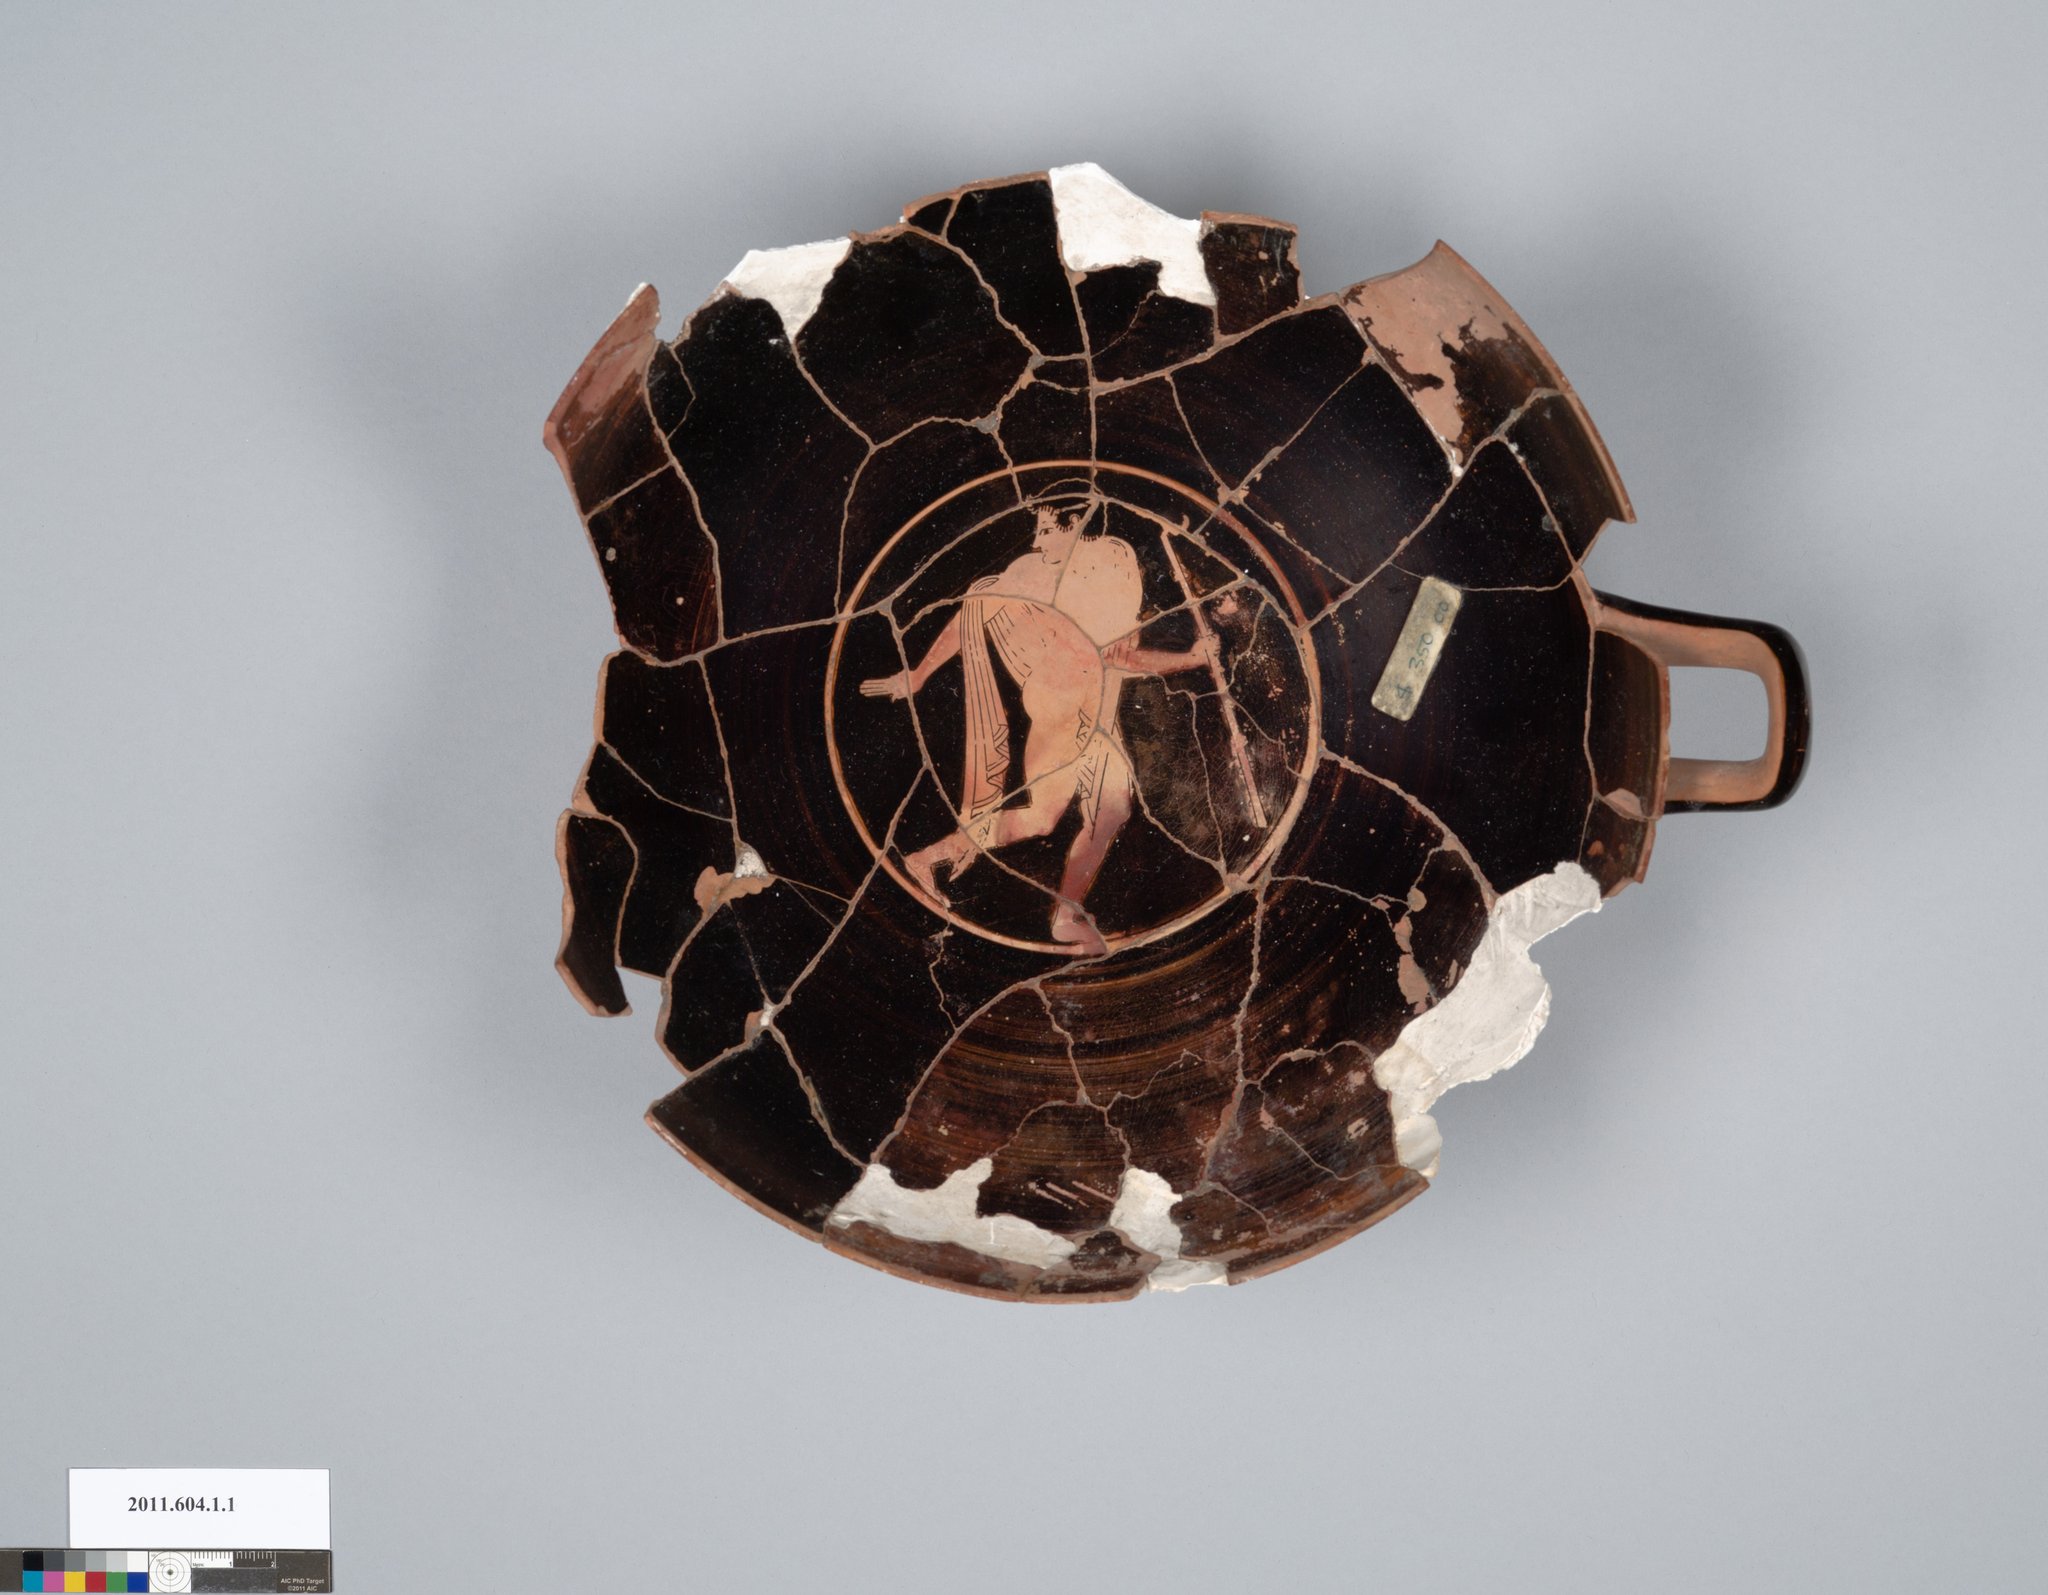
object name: kylix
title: Terracotta kylix (drinking cup)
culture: greek, attic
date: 510-500 BCE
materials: terracotta